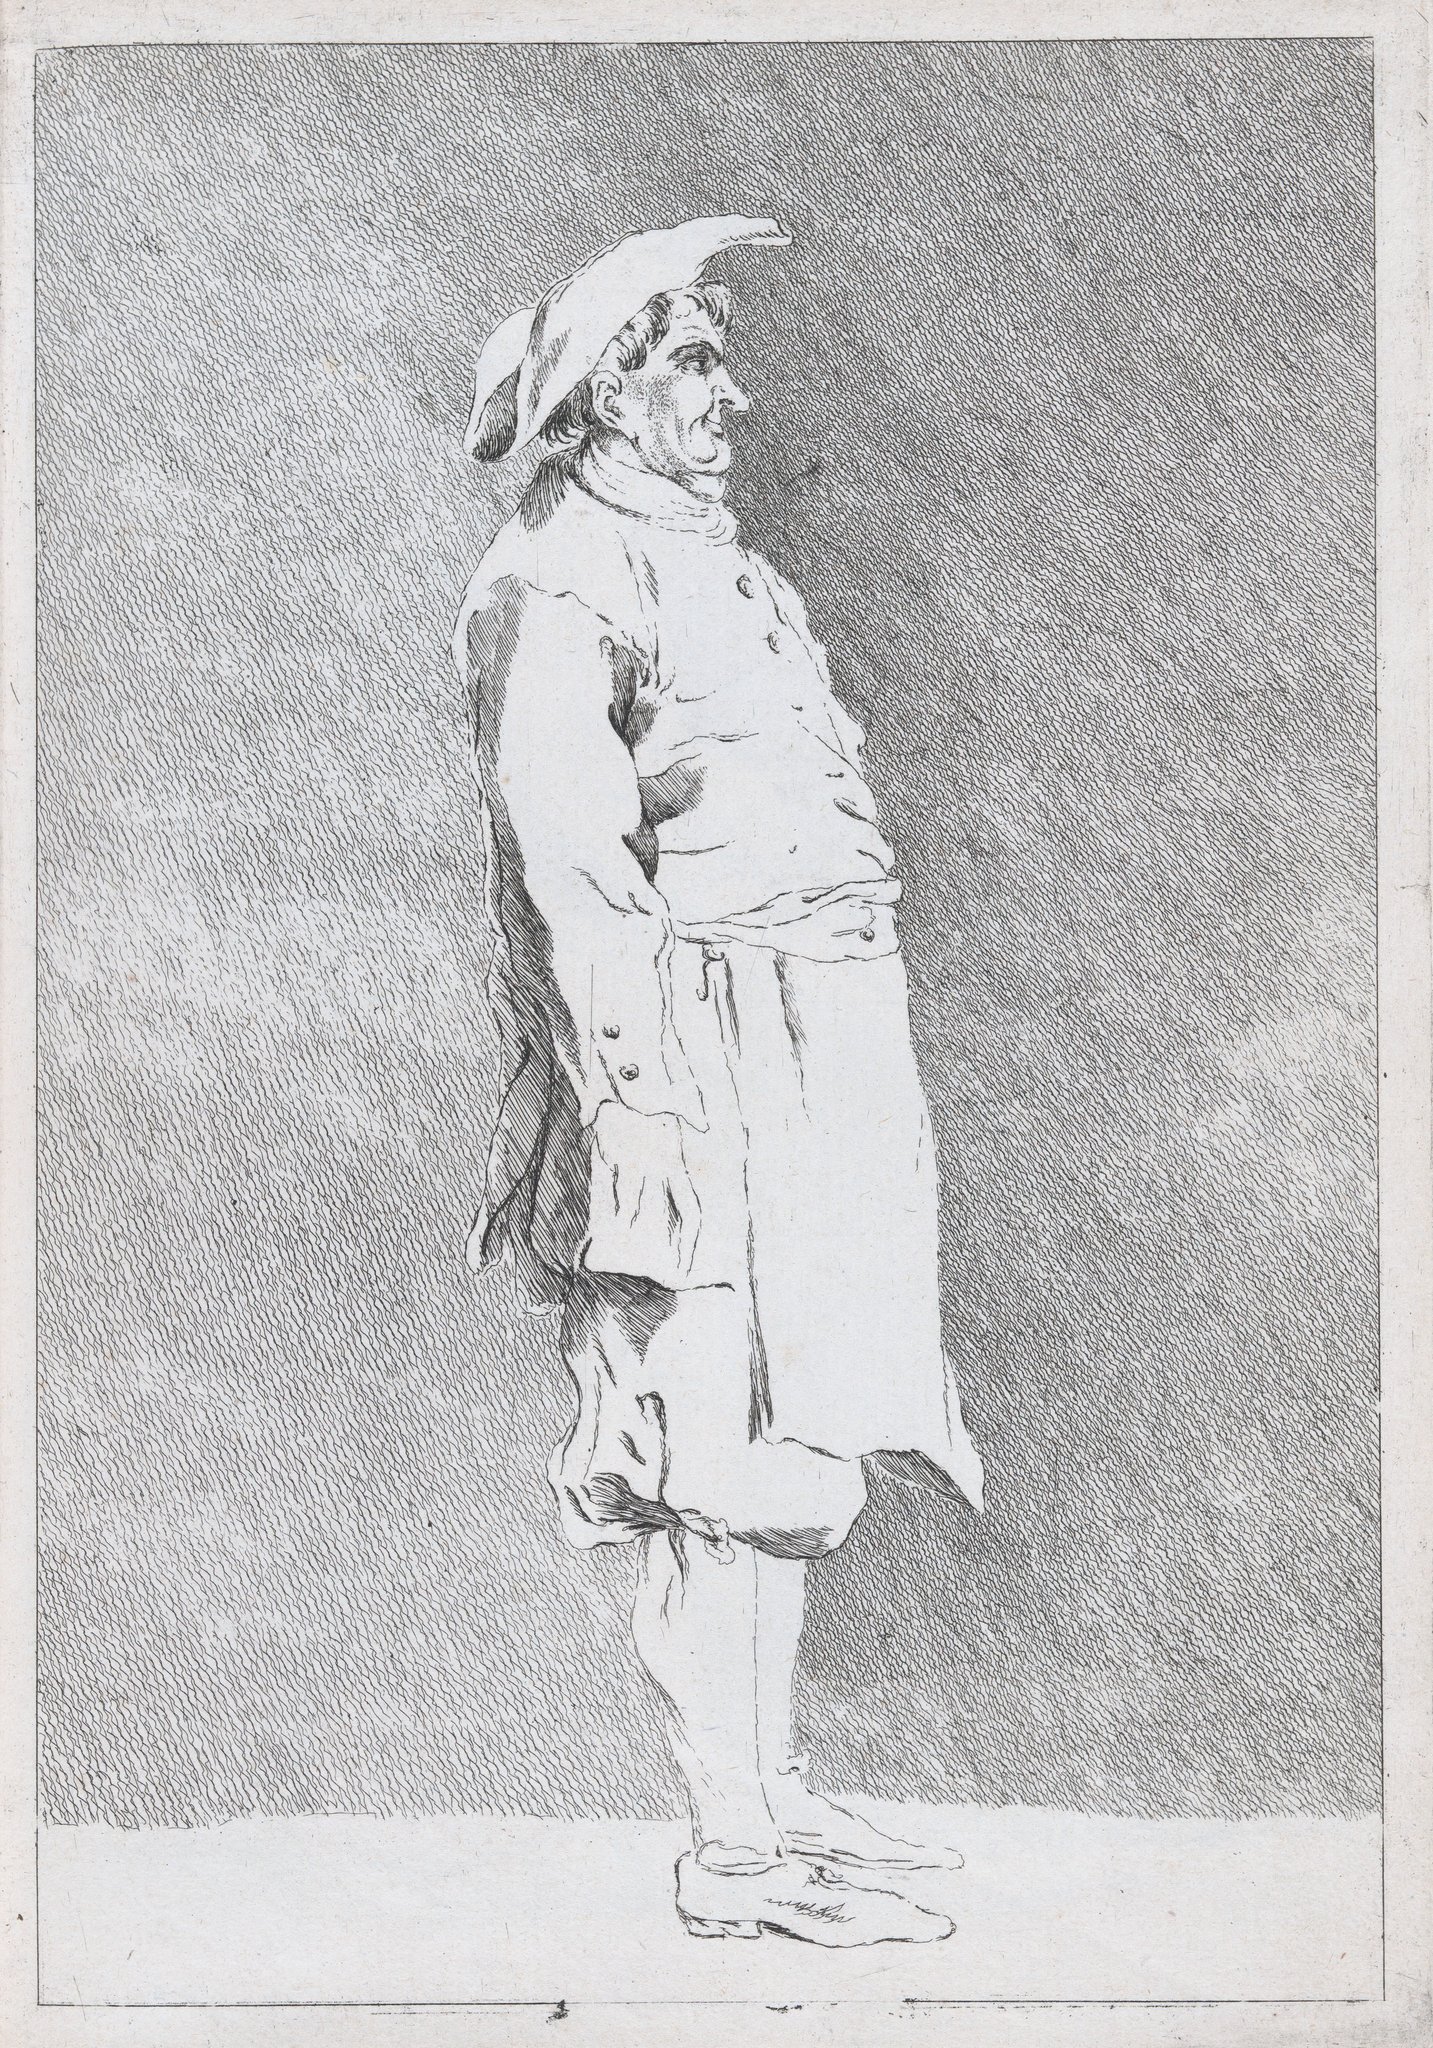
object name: print, album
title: Nicola Zabaglia, pl. XVII from "Recueil de caricatures"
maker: ange-laurent de la live de jully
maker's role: artist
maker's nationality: french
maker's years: 1725-1779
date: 1754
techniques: etching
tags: men,caricature